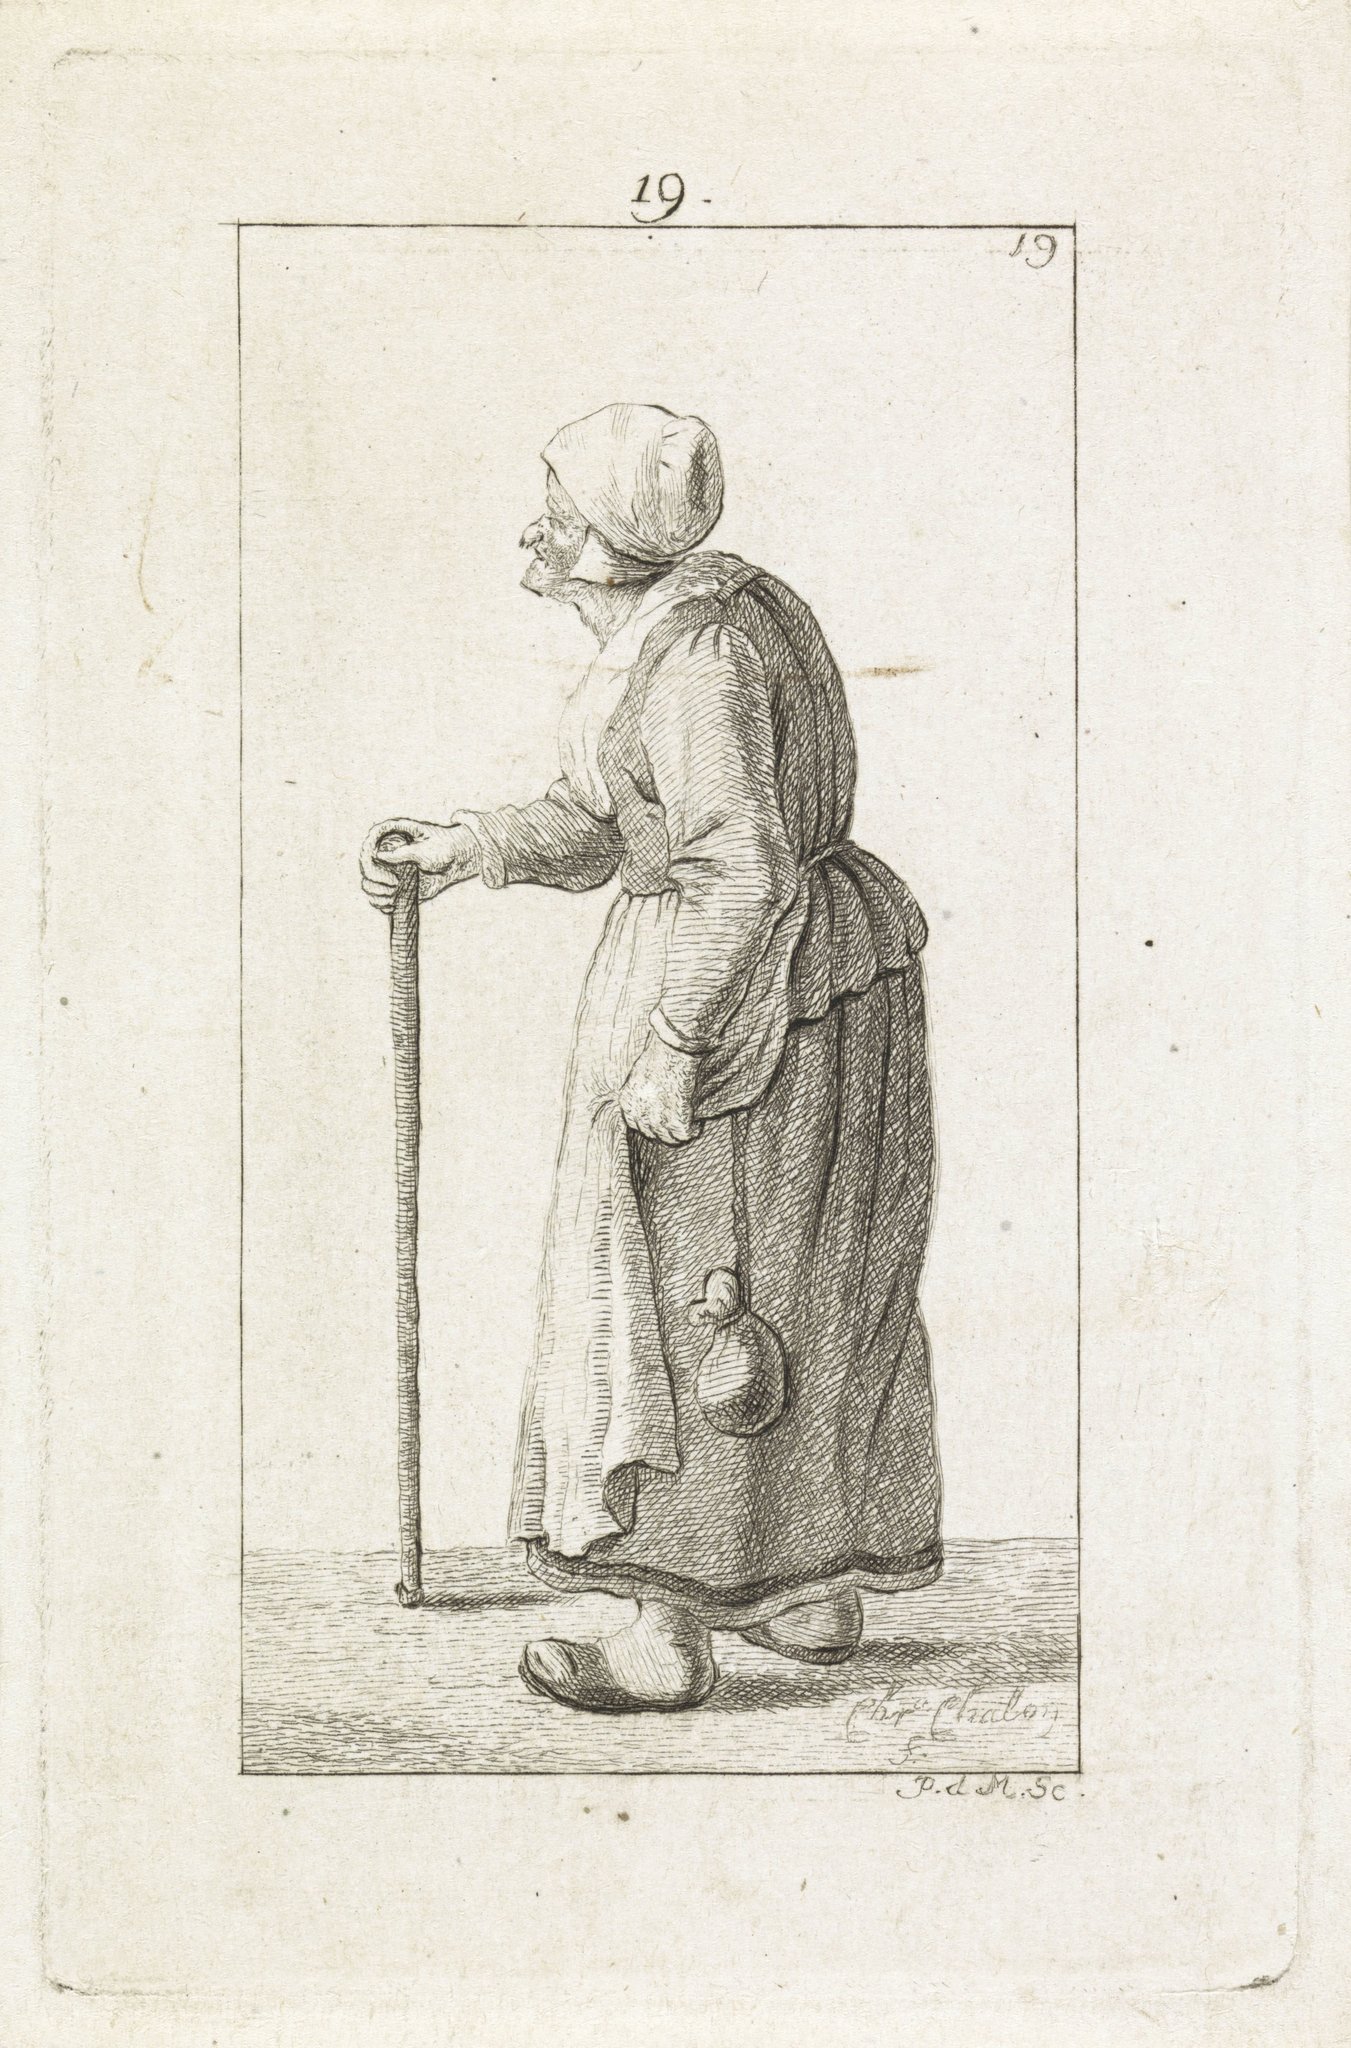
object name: print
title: Oude vrouw met stok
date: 1779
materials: paper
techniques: engraving, etching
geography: netherlands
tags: folk costume, regional costume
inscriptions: collector's mark: Lugt 2228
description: Staande oude vrouw met een wandelstok. Onderdeel van een reeks illustraties van volksklederdrachten uit 1779.